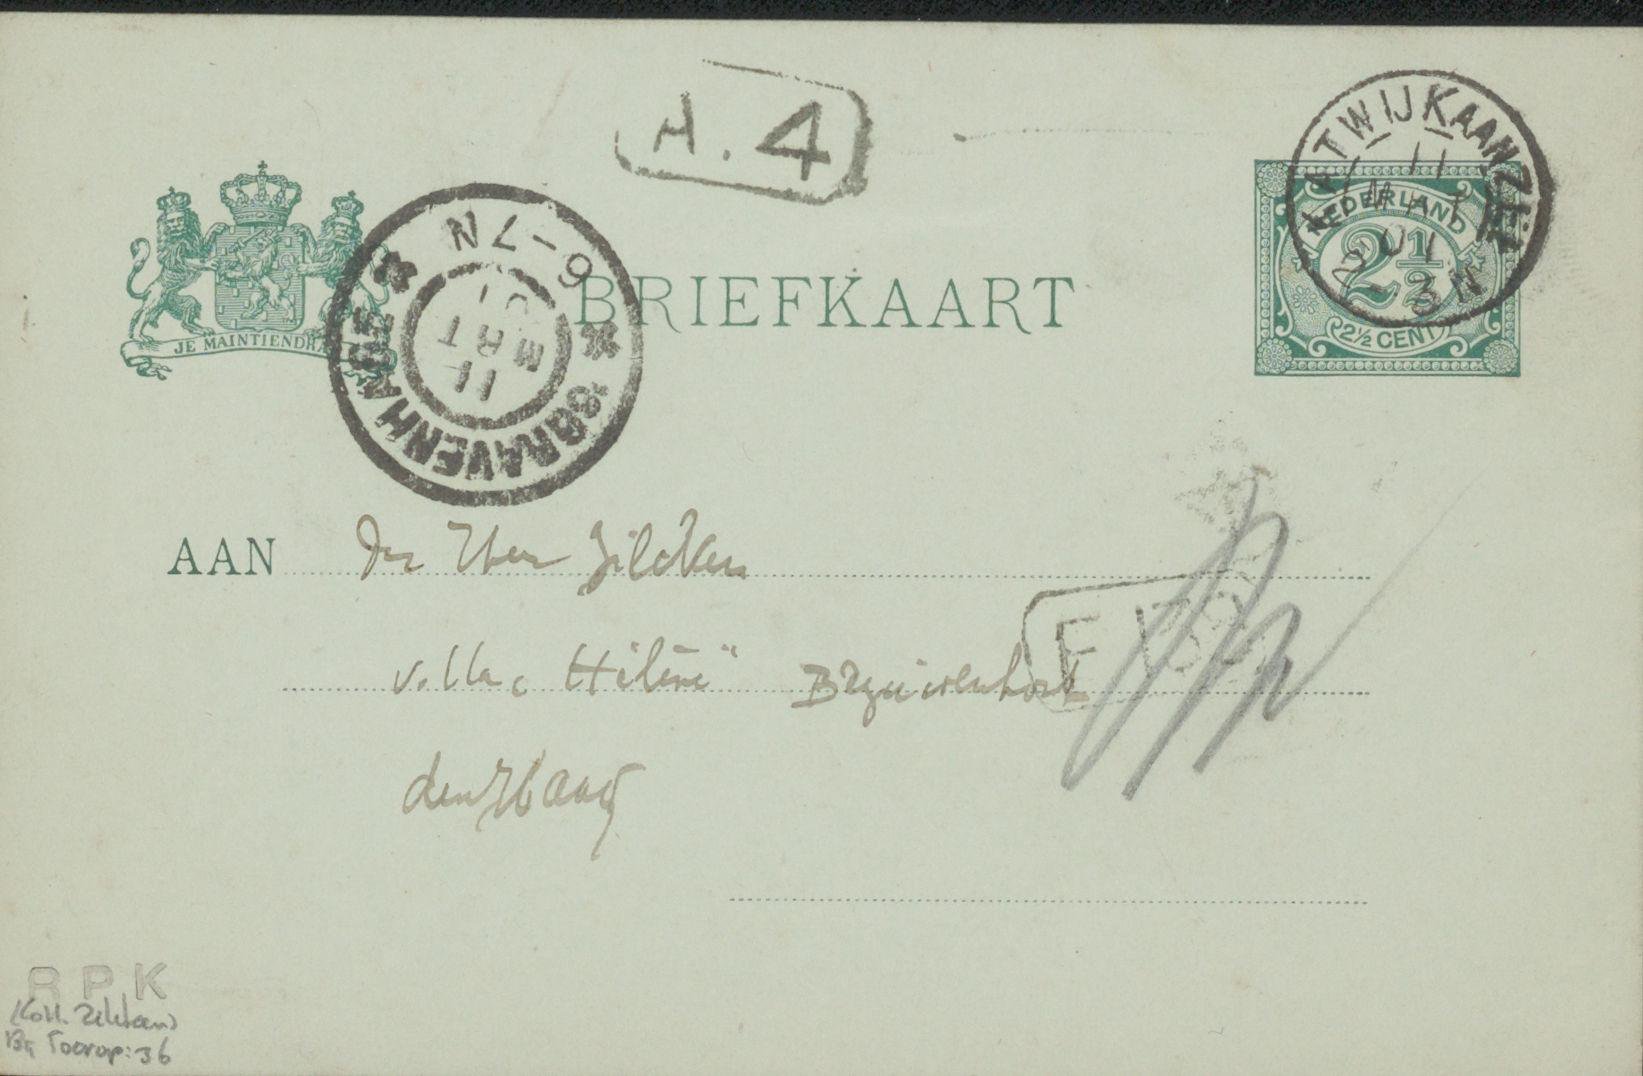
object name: postcard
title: Briefkaart aan Philip Zilcken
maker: jan toorop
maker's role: draughtsman, painter, print maker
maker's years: 1858-1928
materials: cardboard, ink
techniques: pen, writing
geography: katwijk aan zee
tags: the hague, print maker, draughtsman, carel nicolaas storm van 's-gravesande, willy sluiter, designer, lambertus zijl, willem leuring, painter, philip zilcken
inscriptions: collector's mark: ‘RPK’